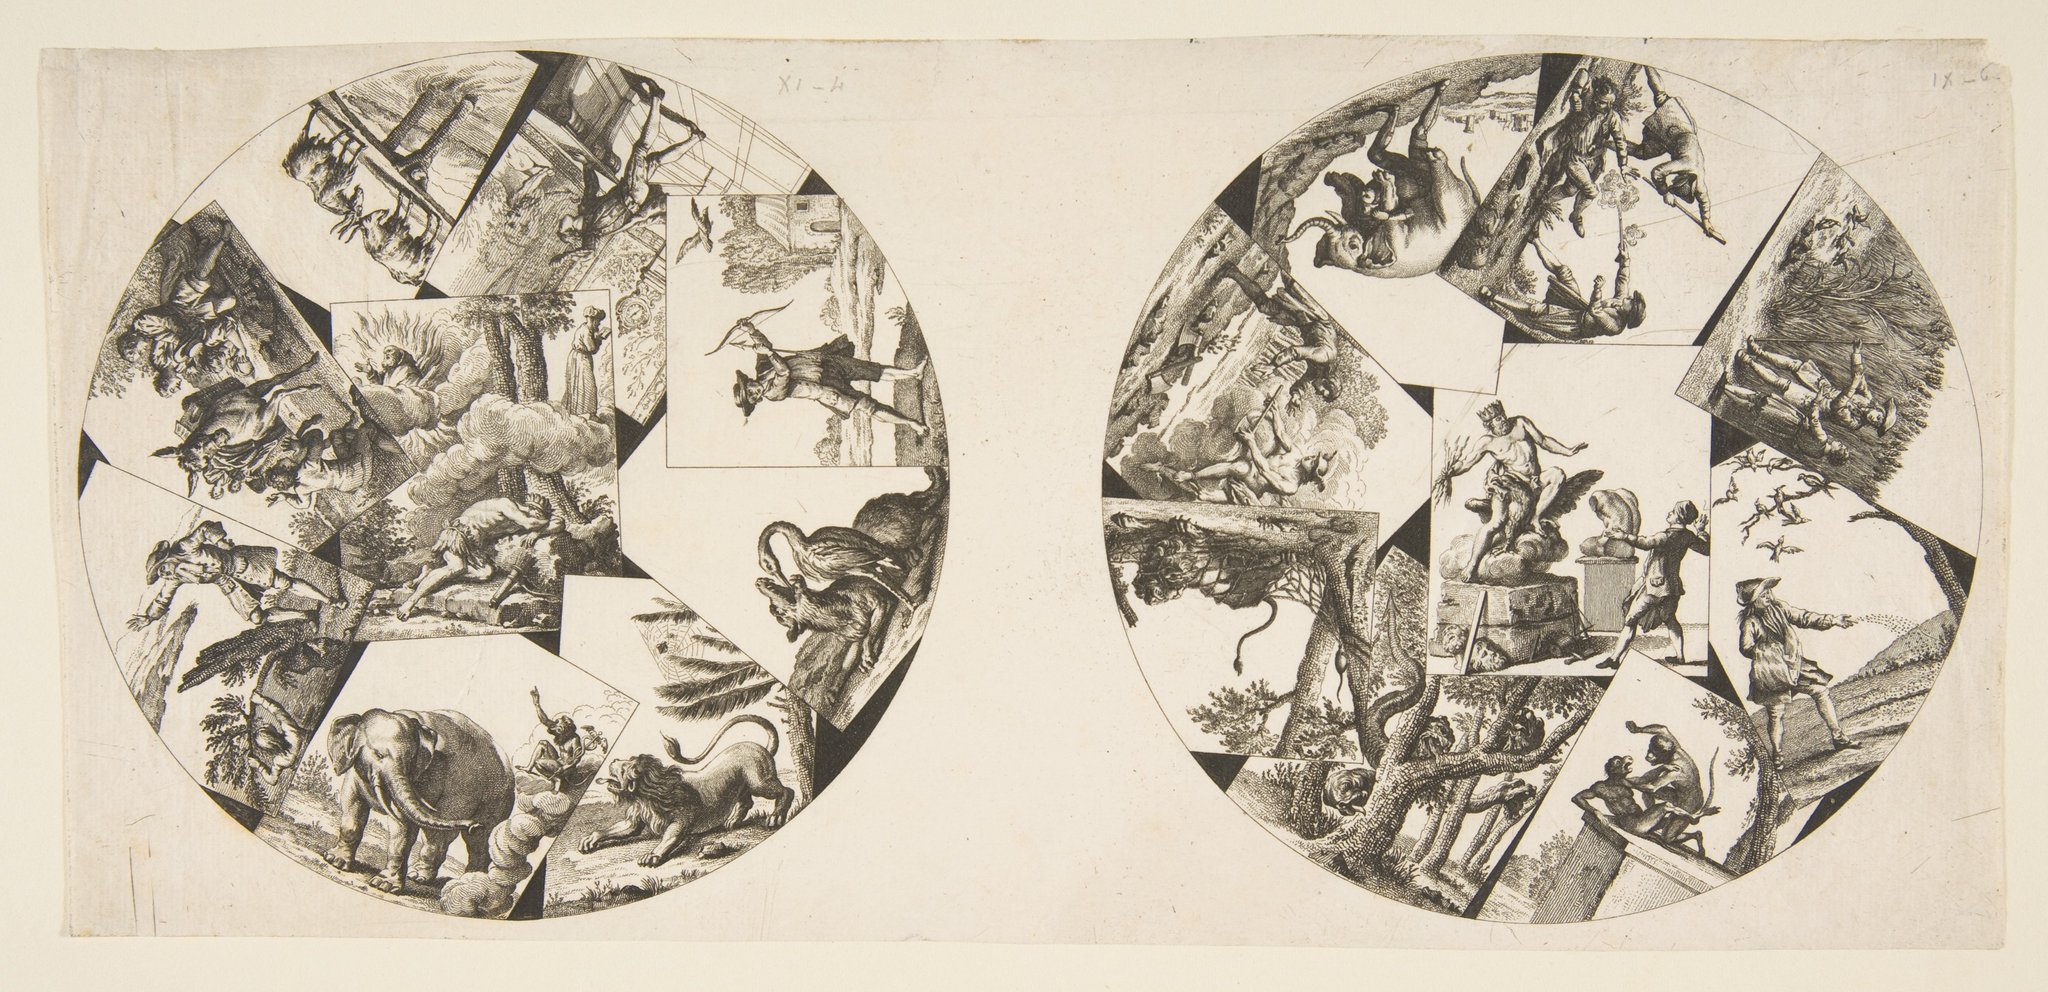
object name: print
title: Designs for Plates Taken from Oudry's Illustrations to La Fontaine's Fables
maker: jean-baptiste oudry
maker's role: artist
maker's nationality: french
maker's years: 1686-1755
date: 1755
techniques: etching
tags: animals,birds,men,elephants,lions